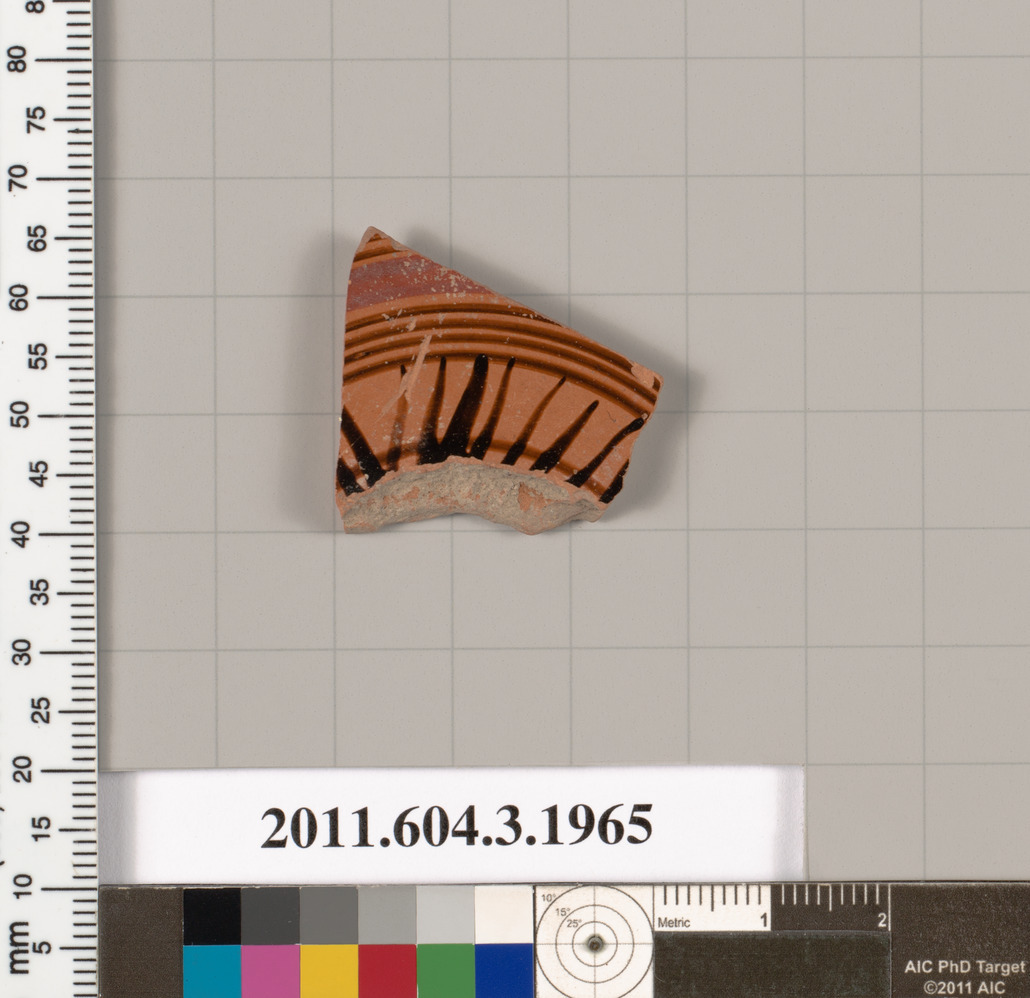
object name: kylix fragment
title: Terracotta fragment of a kylix (drinking cup)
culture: greek, attic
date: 550-526 BCE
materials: terracotta